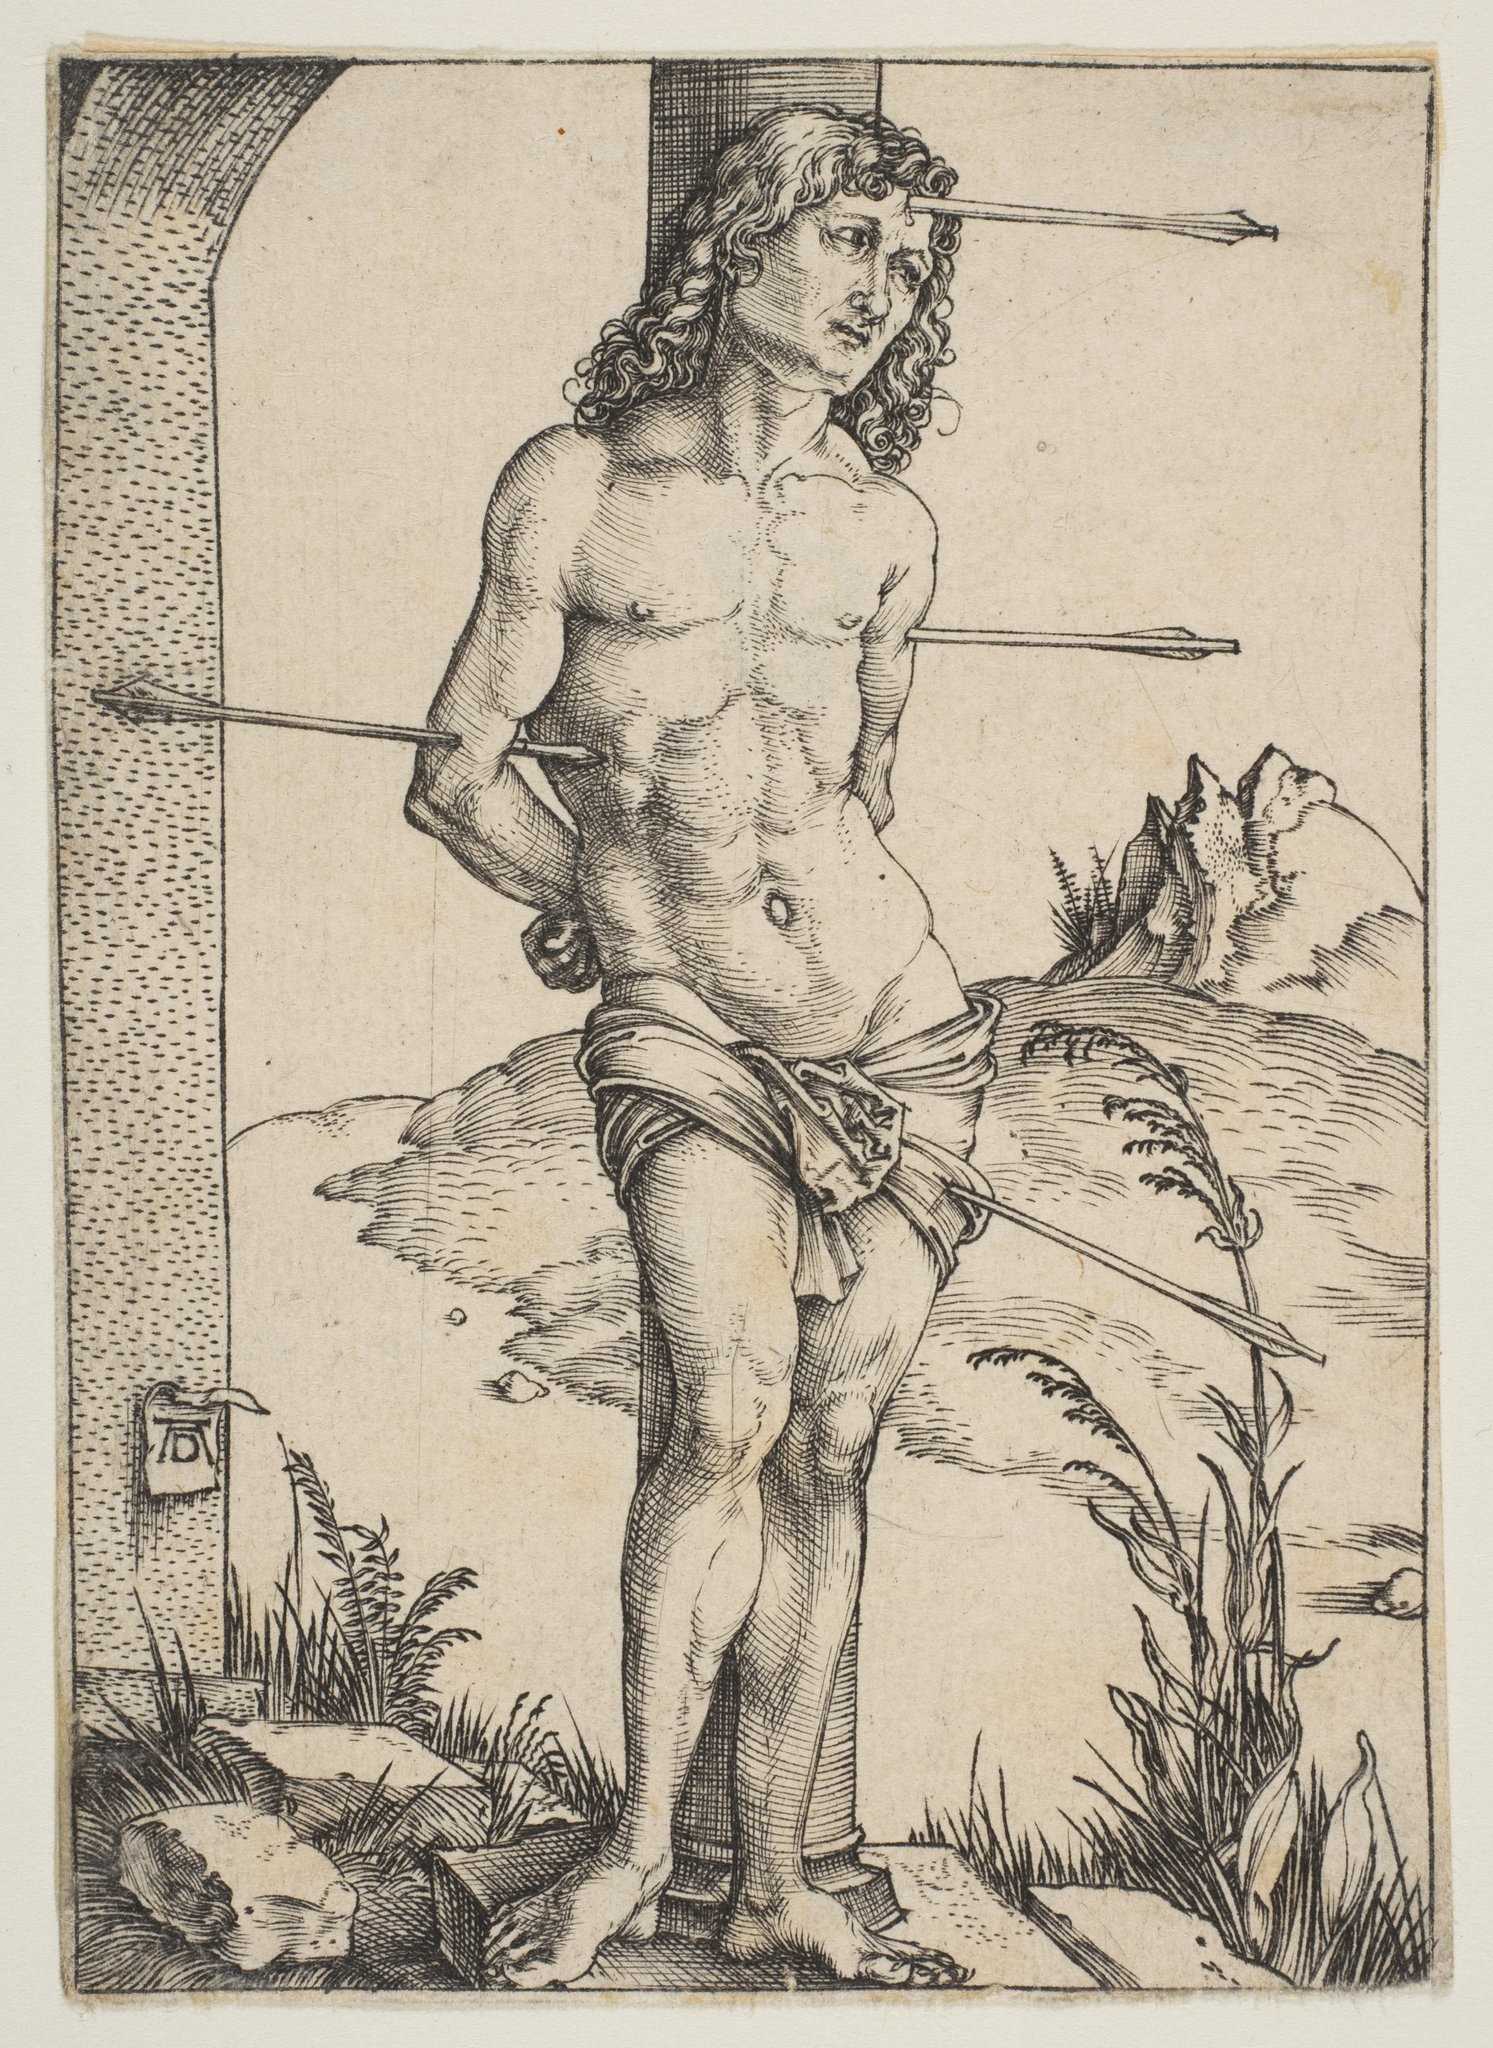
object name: print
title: Saint Sebastian Bound to the Column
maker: albrecht dürer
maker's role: artist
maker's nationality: german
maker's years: 1471-1528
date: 1499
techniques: engraving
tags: arrows,suffering,men,saint sebastian